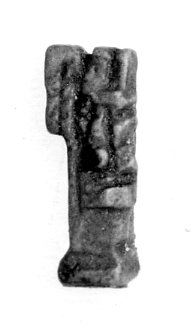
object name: amulet, min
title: Min amulet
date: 664-332 BCE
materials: faience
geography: egypt